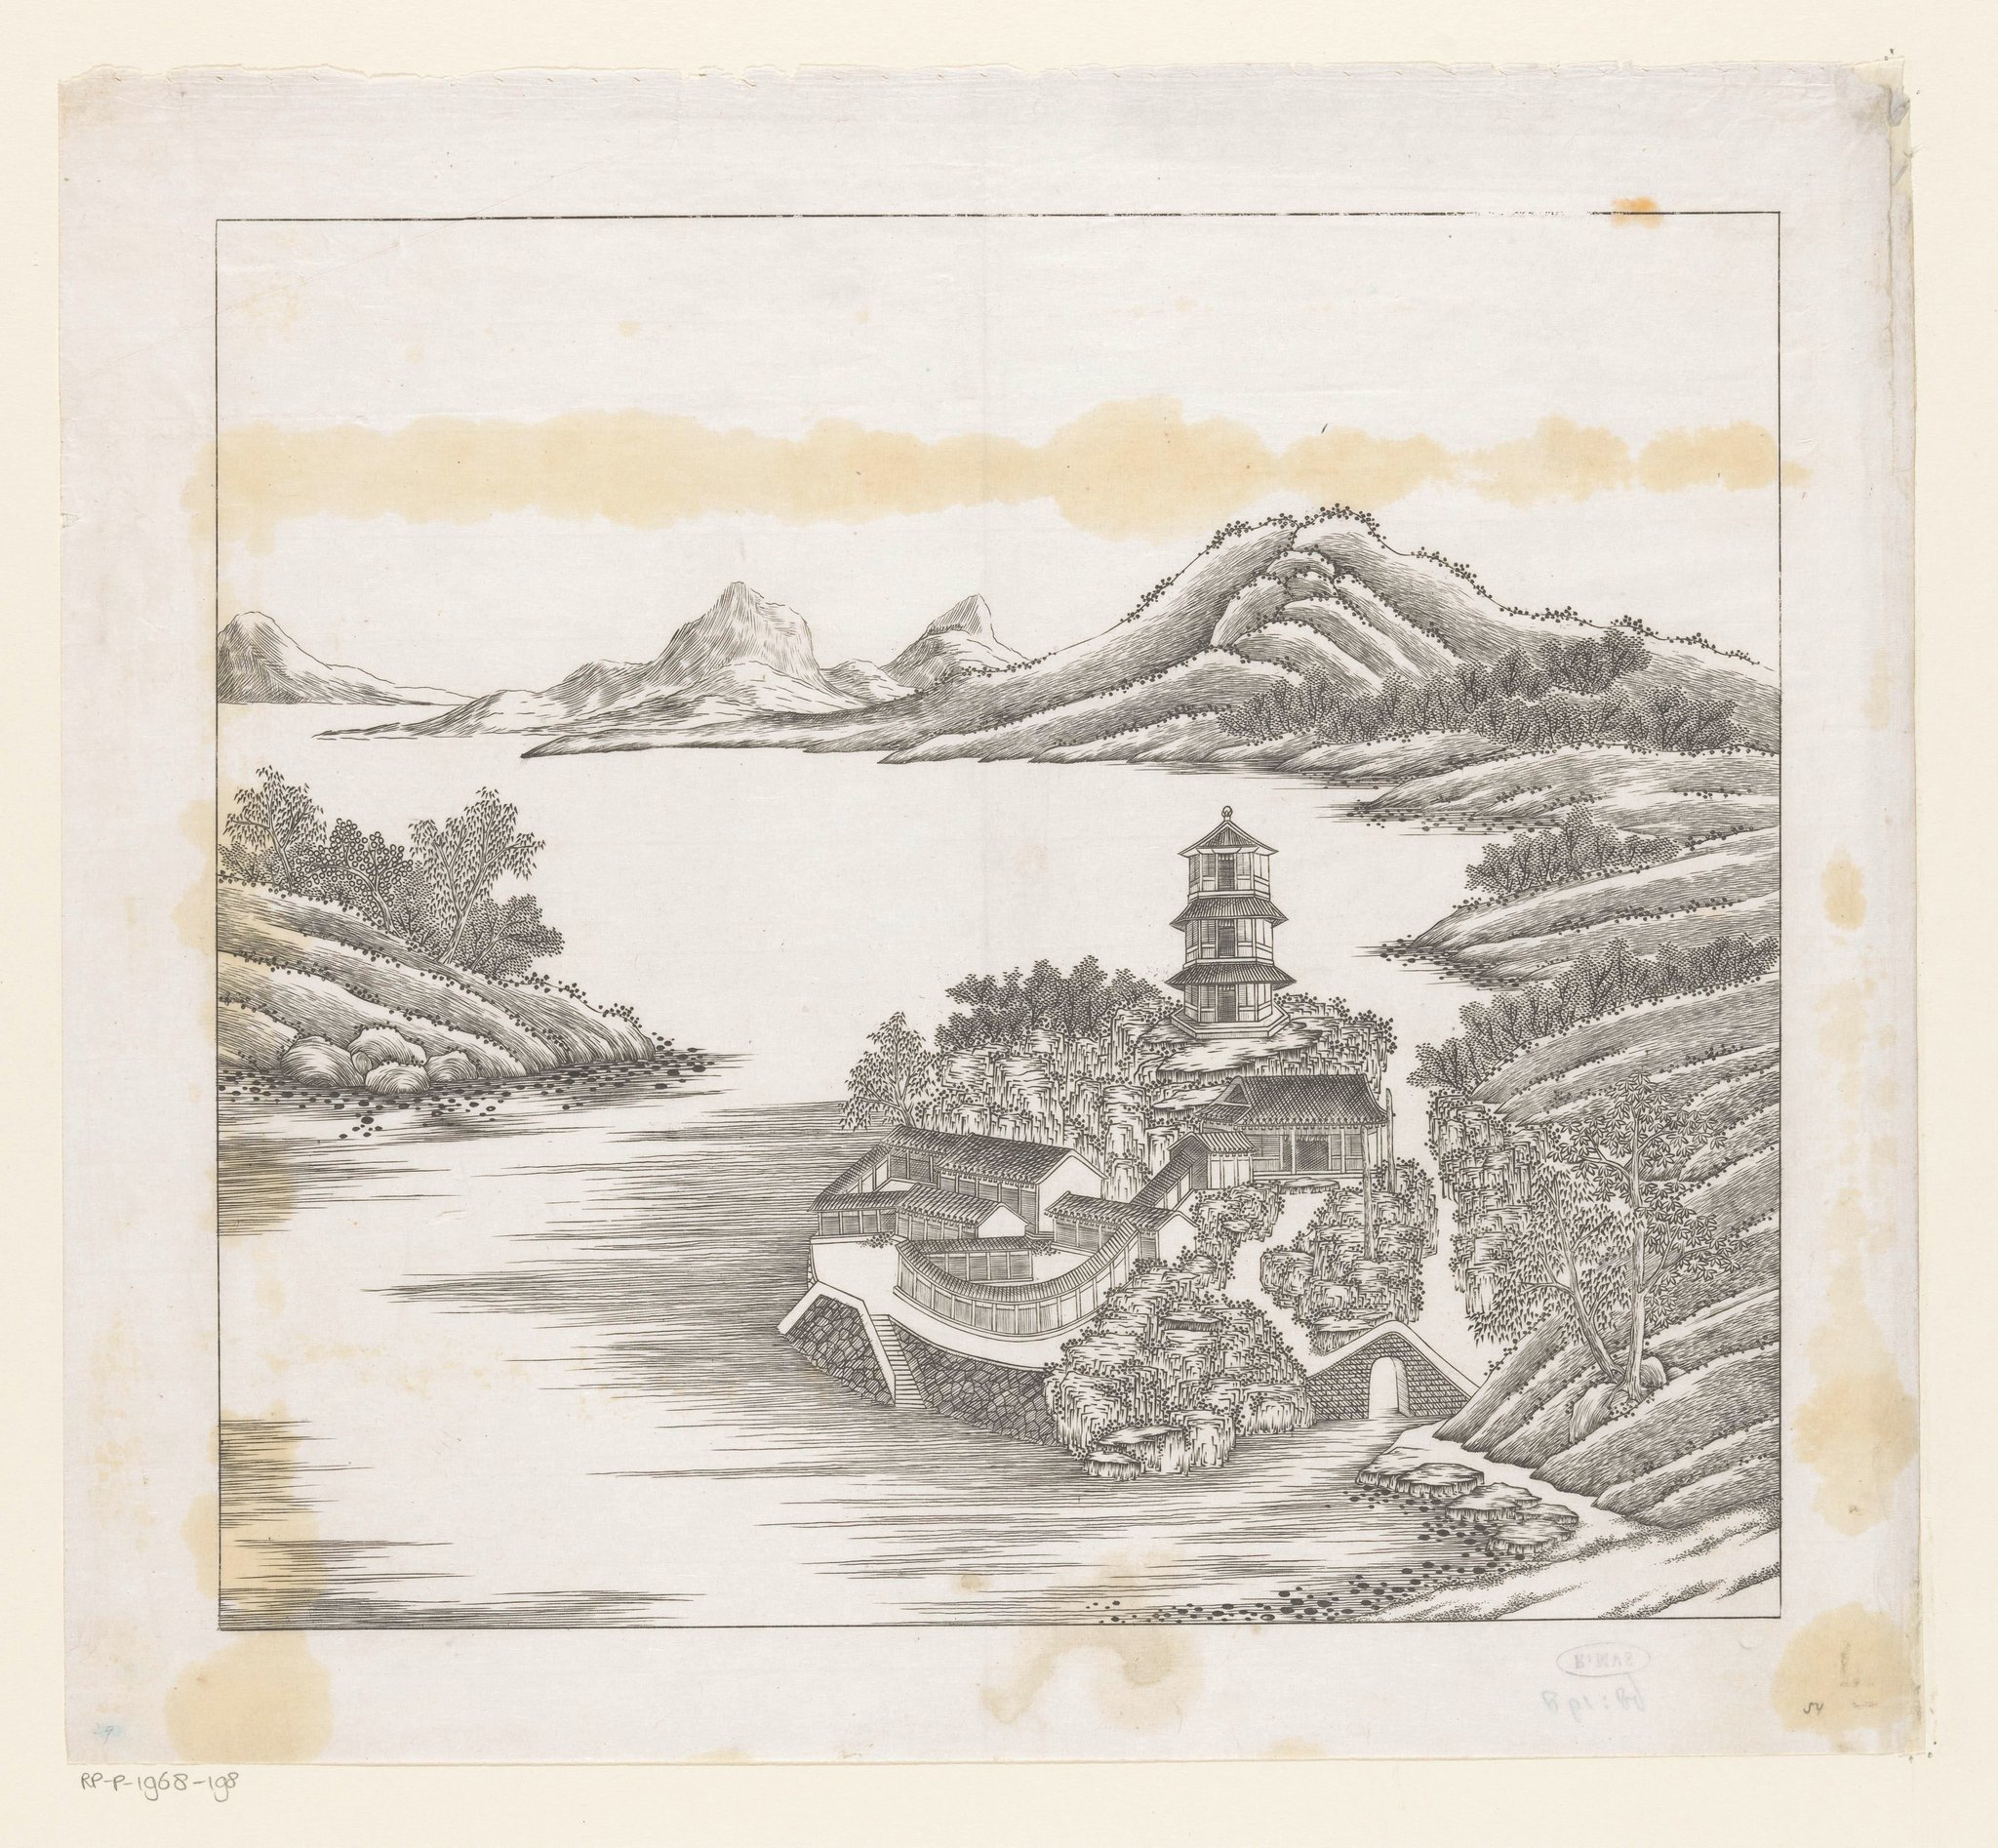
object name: print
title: Gezicht op een deel van het keizerlijk zomerpaleis in Chengde (Jehol) te China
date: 1712-1714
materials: paper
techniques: engraving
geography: china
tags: city-view, and landscape with man-made constructions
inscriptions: collector's mark: Lugt 2228, collector's mark: ‘GW’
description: Achttiende prent uit een serie van 36 prenten met gezichten op het keizerlijk zomerverblijf te Chengde (Jehol). De Italiaanse missionaris Matteo Ripa verbleef tussen 1711-1723 als kunstenaar aan hof van keizer Kangxi. Hij vervaardigde deze prentserie in samenwerking met enkele Chinese prentmakers. Uitgangspunt voor de ontwerpen van Shen Yu vormden de gedichten geschreven door keizer Kangxi. Het Rijksmuseum Amsterdam bezit 31 prenten van de serie. Twee andere prenten uit deze set worden bewaard in het British Museum (1968,0212,0.27 en 1968,0212,0.28).